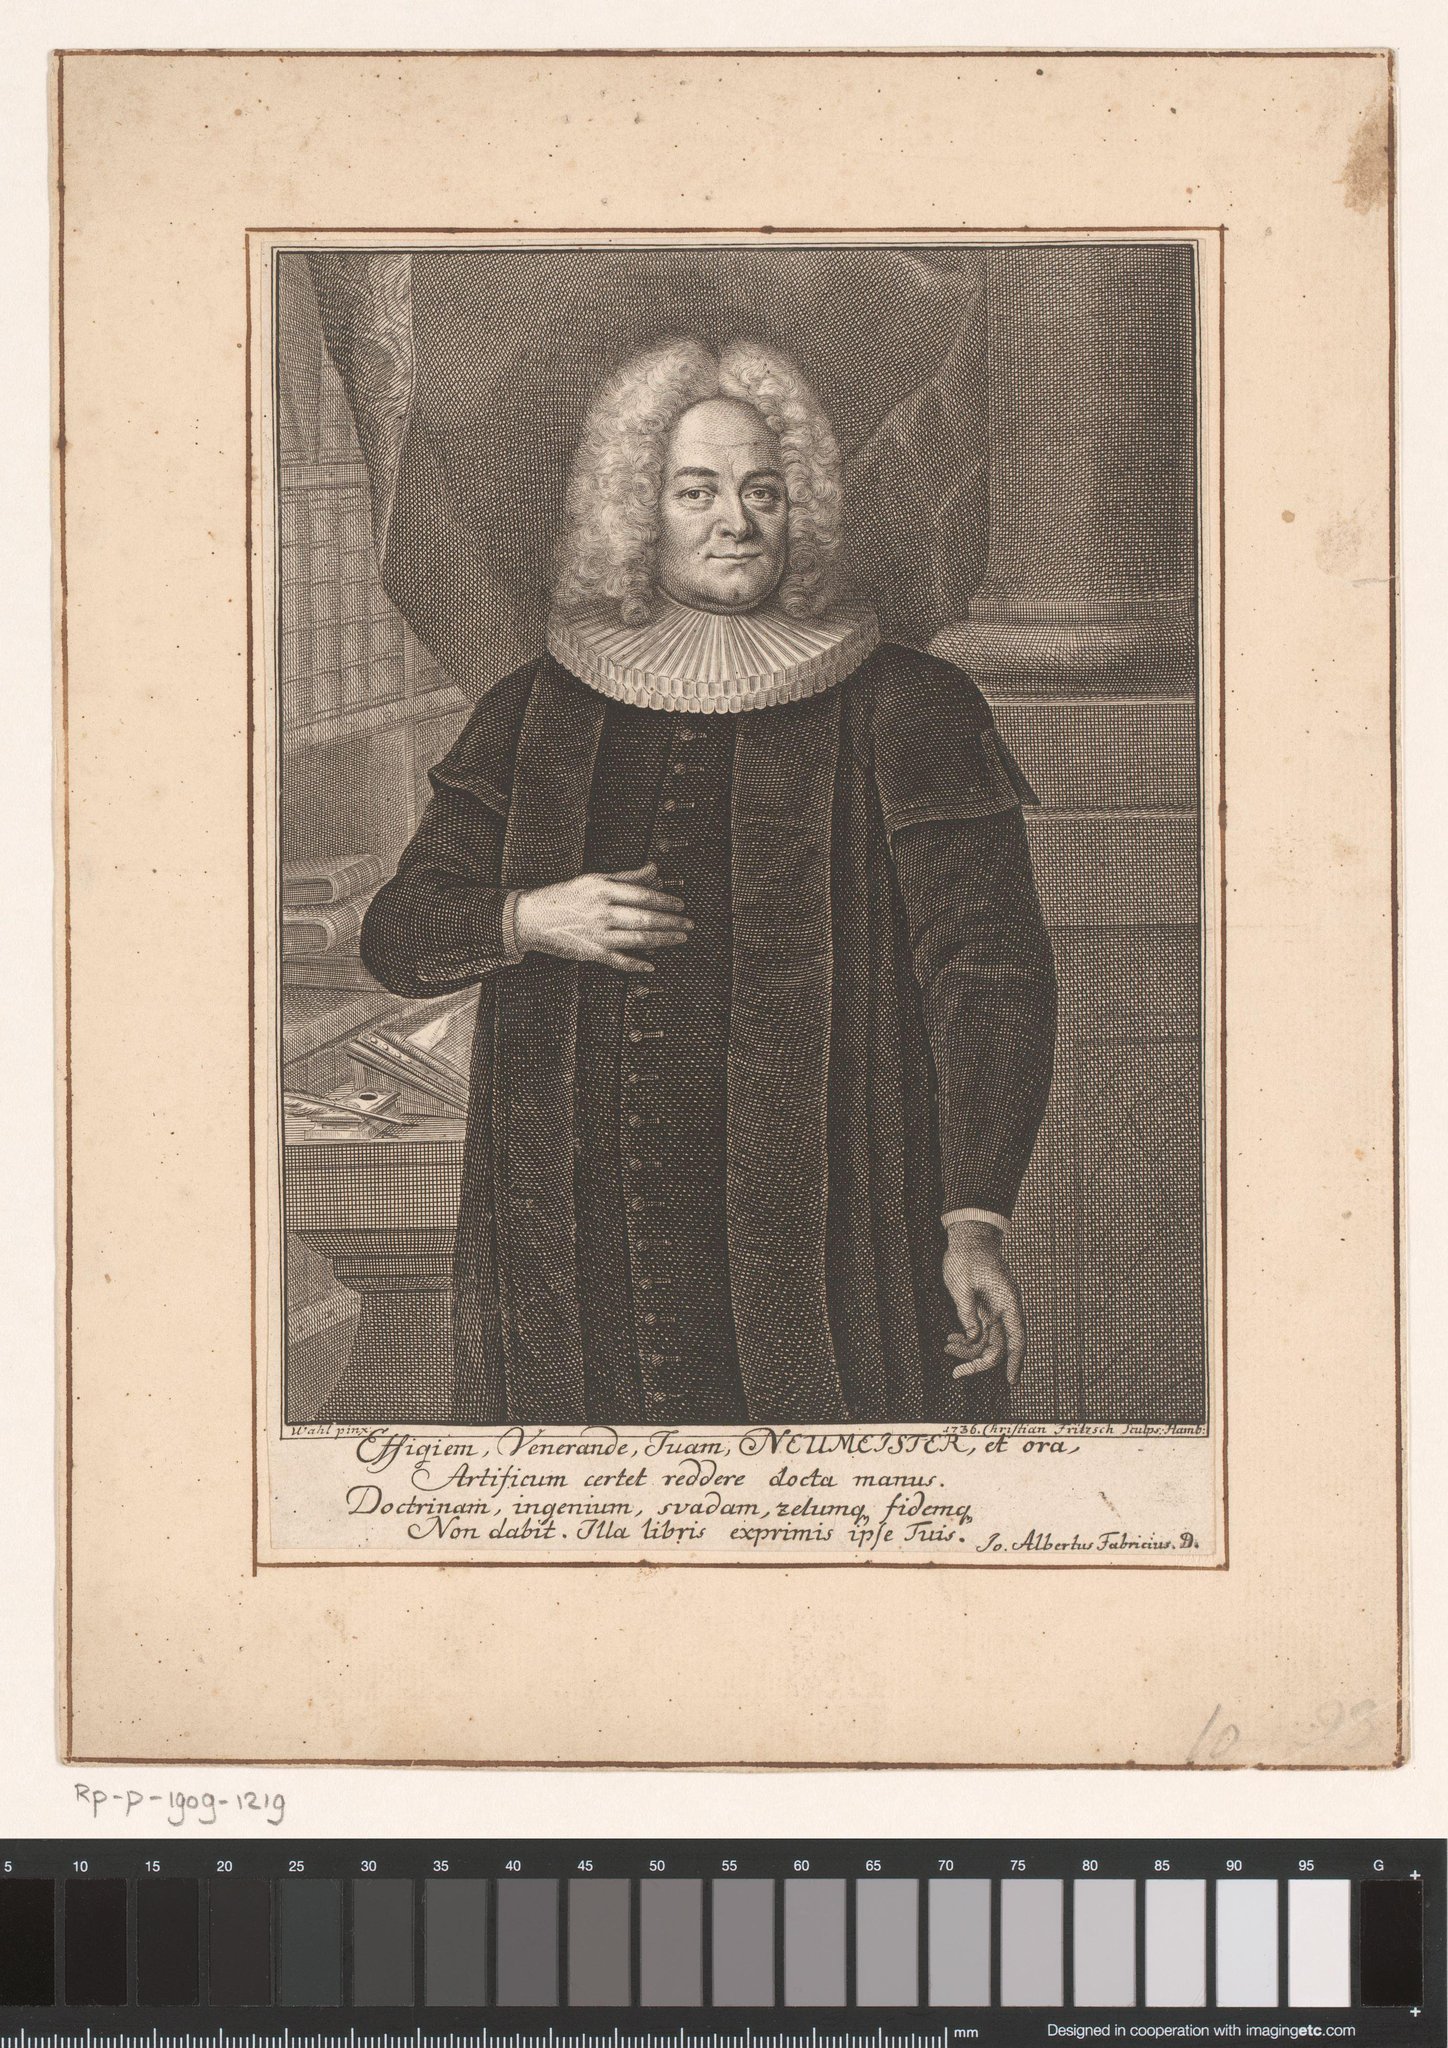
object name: print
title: Portret van Erdmann Neumeister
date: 1736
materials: paper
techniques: engraving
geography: hamburg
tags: erdmann neumeister, bookshelves, writing tools, historical persons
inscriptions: collector's mark: Lugt 2228